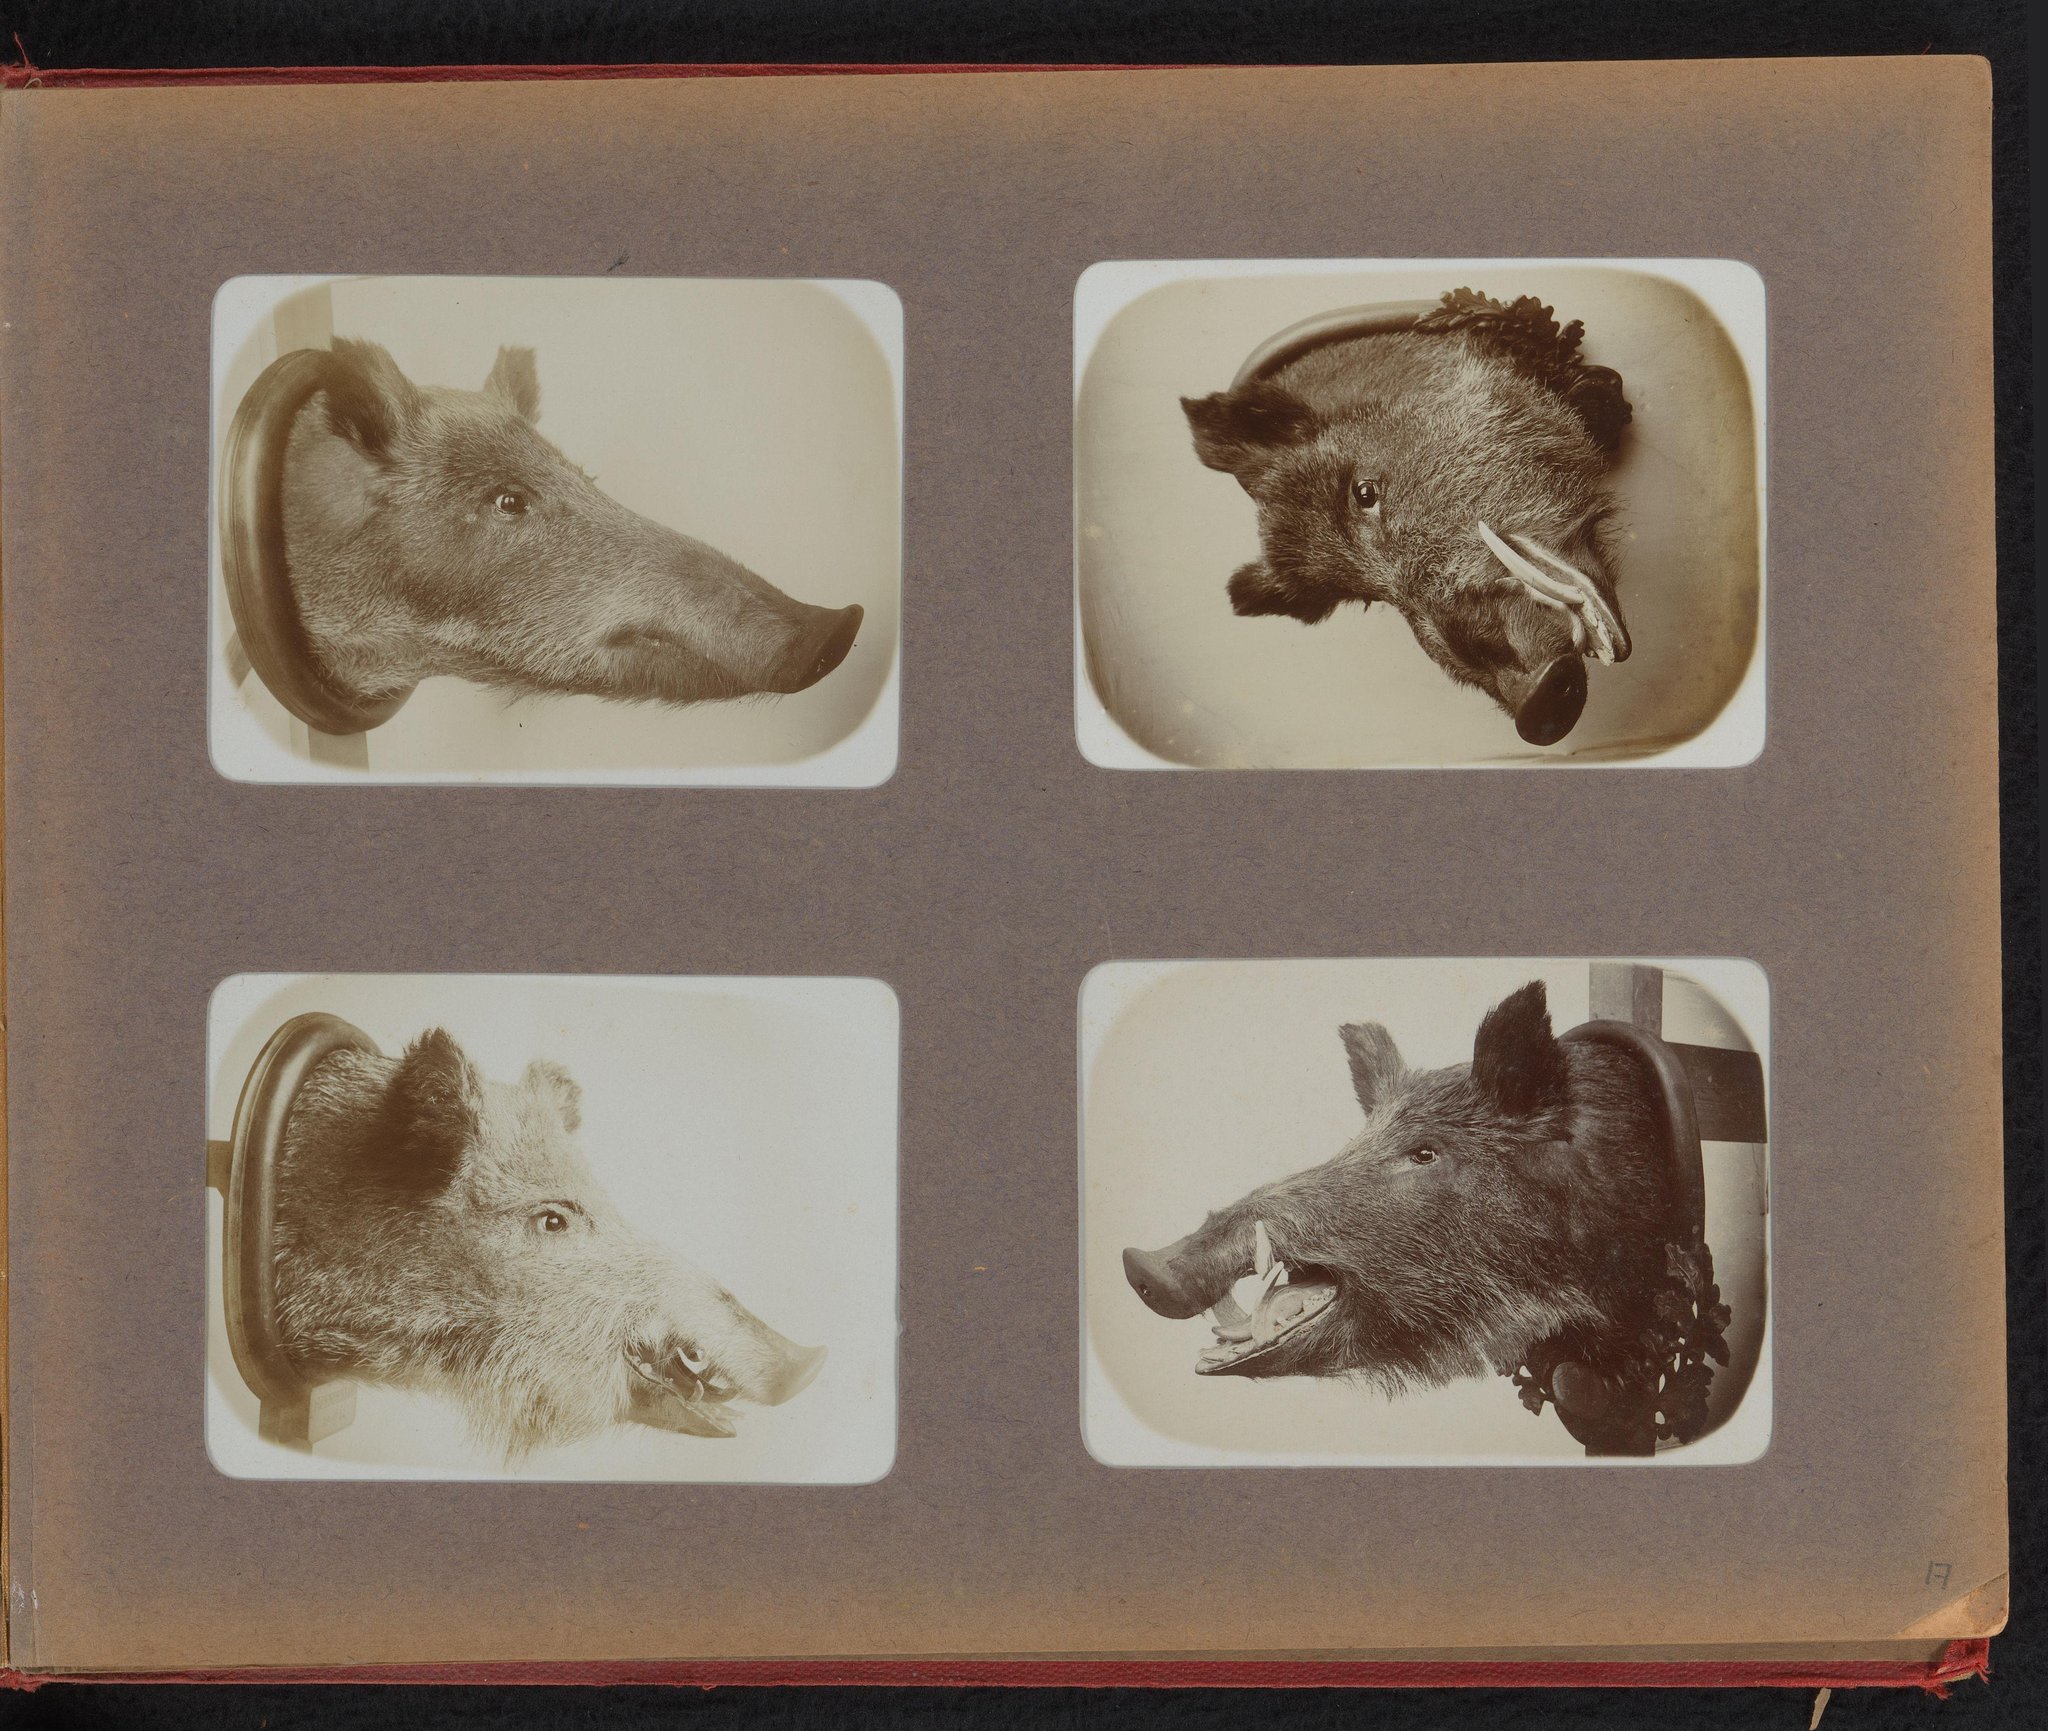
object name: album leaf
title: Opgezette zwijnenkoppen, gemonteerd op planken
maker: Anonymous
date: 1895-1910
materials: paper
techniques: gelatin silver print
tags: boar (male pig), hoofed animals: boar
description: Deze foto's maken deel uit van een album.